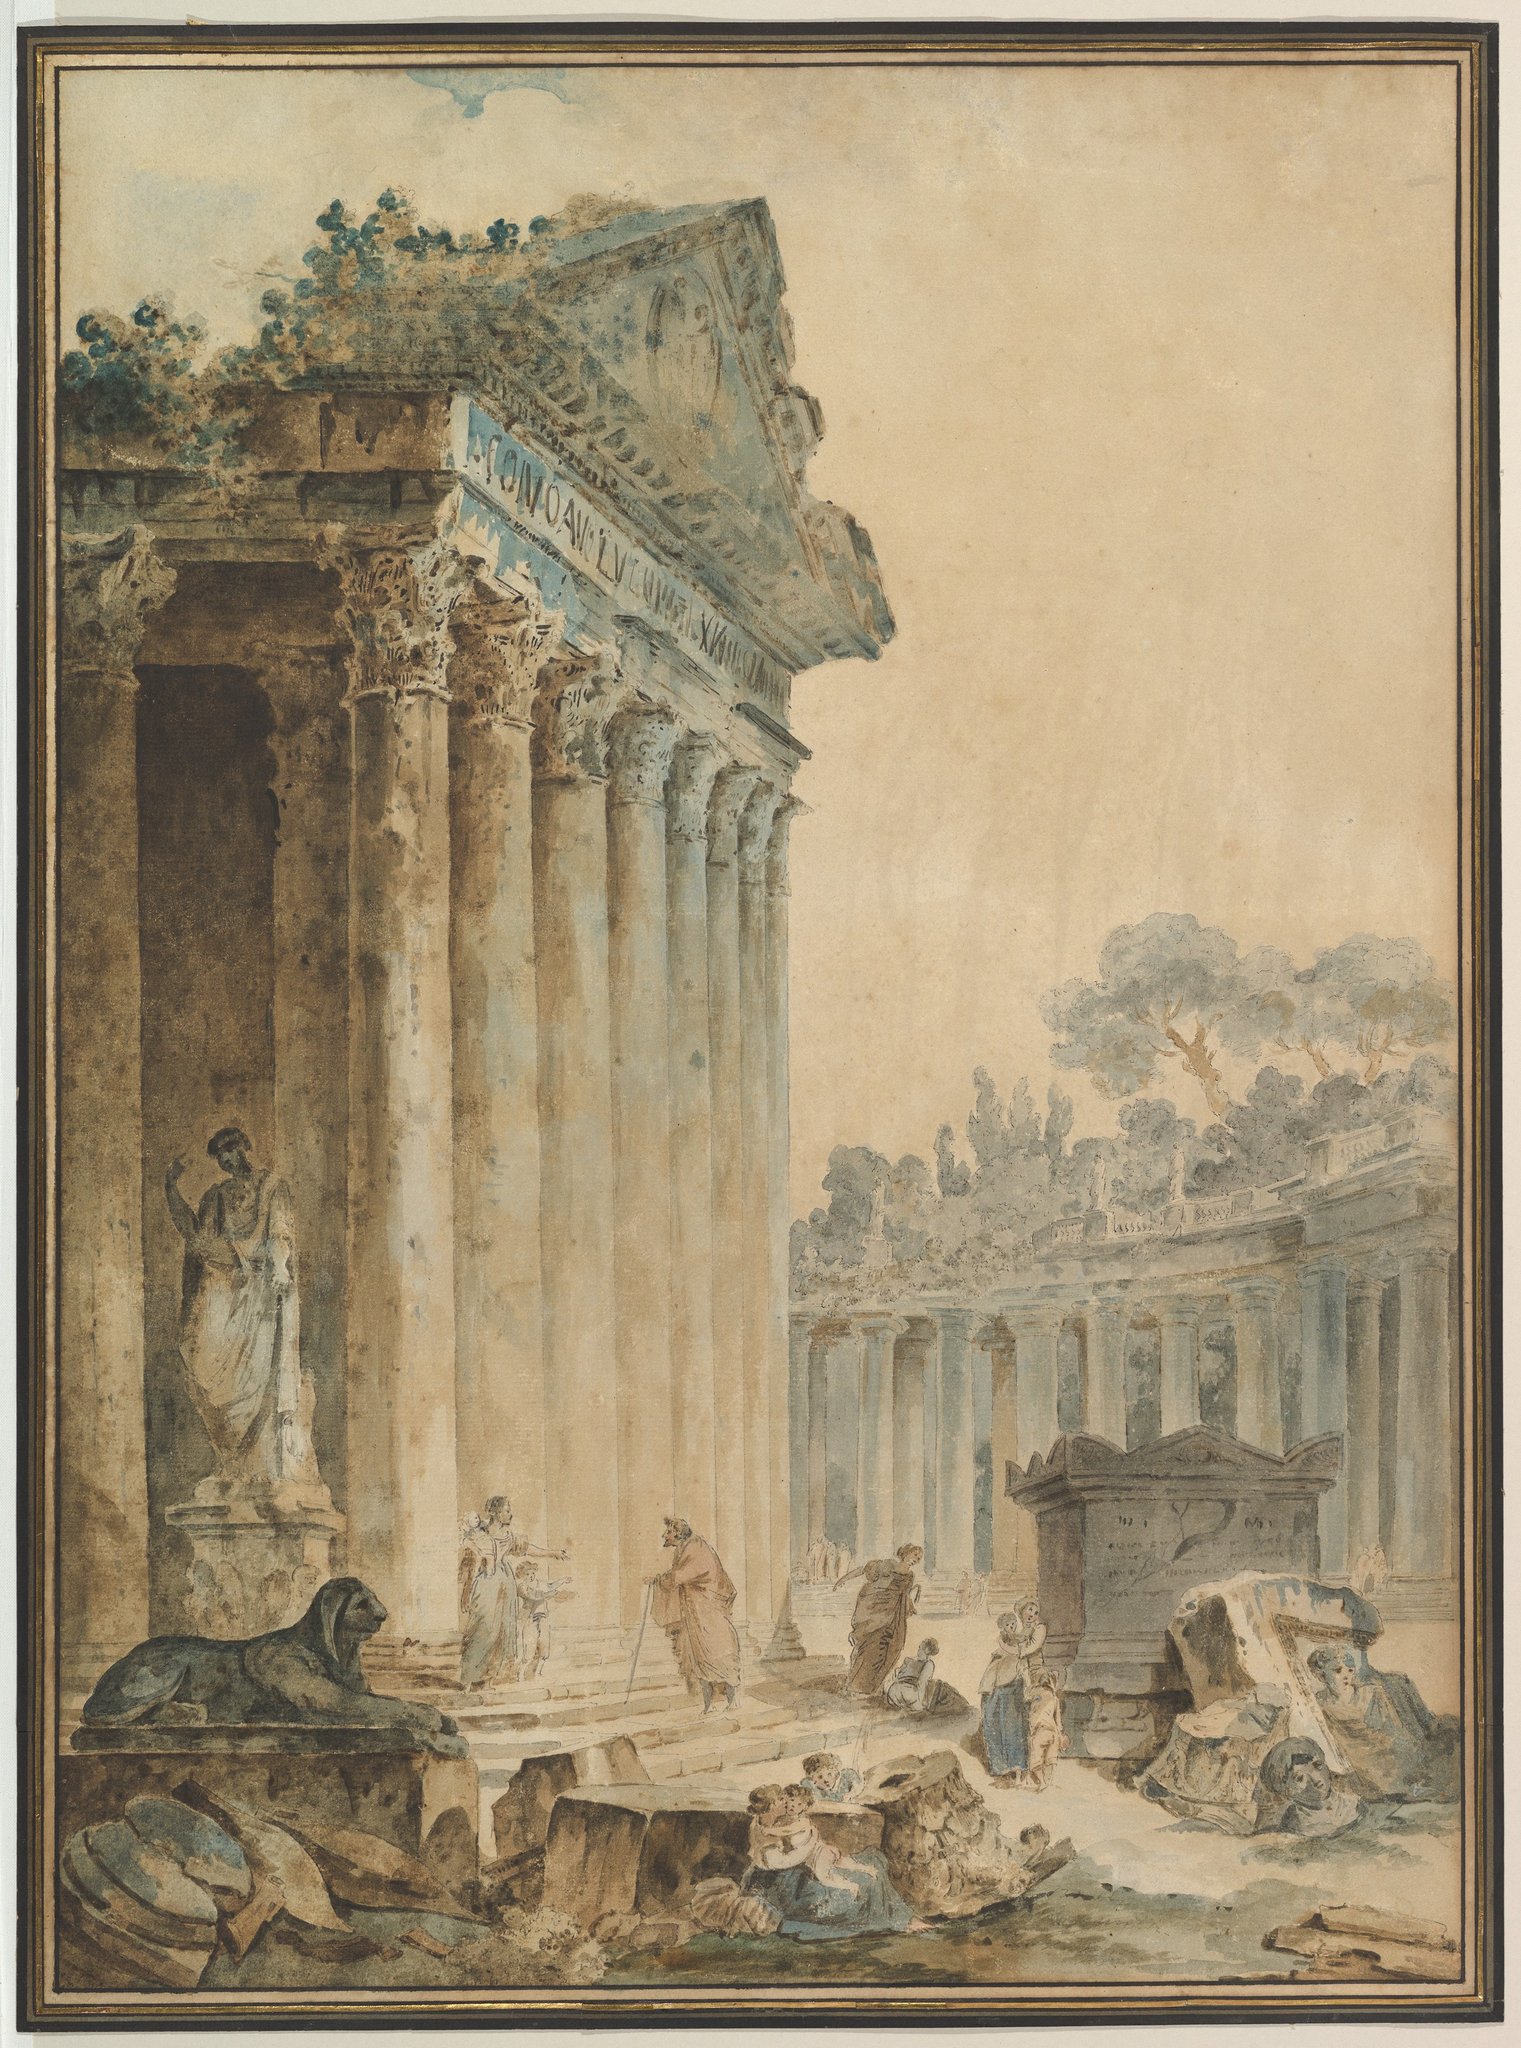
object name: drawing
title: Capriccio with an Ancient Temple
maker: hubert robert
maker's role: artist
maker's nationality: french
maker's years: 1733-1808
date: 1756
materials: chalk, ink, paper, watercolor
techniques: pen, drawing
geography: france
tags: columns,temples